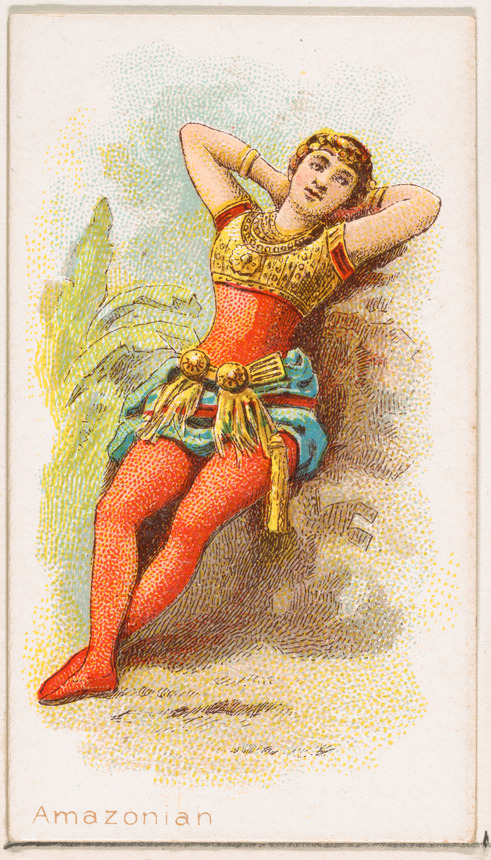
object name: print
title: Amazonian Dancer, from the Dancing Women series (N186) issued by Wm. S. Kimball & Co.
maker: william s. kimball & company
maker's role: publisher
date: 1889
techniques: color lithograph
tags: women,dancers